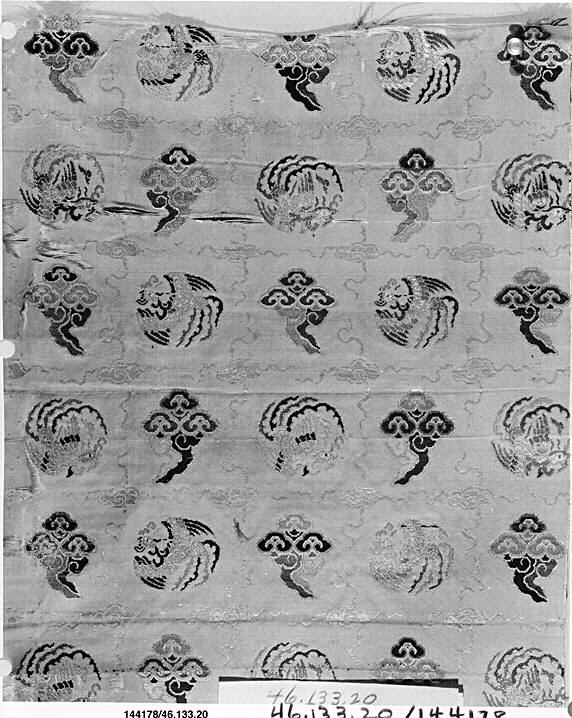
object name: piece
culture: chinese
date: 1601-1700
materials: metal thread, silk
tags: birds